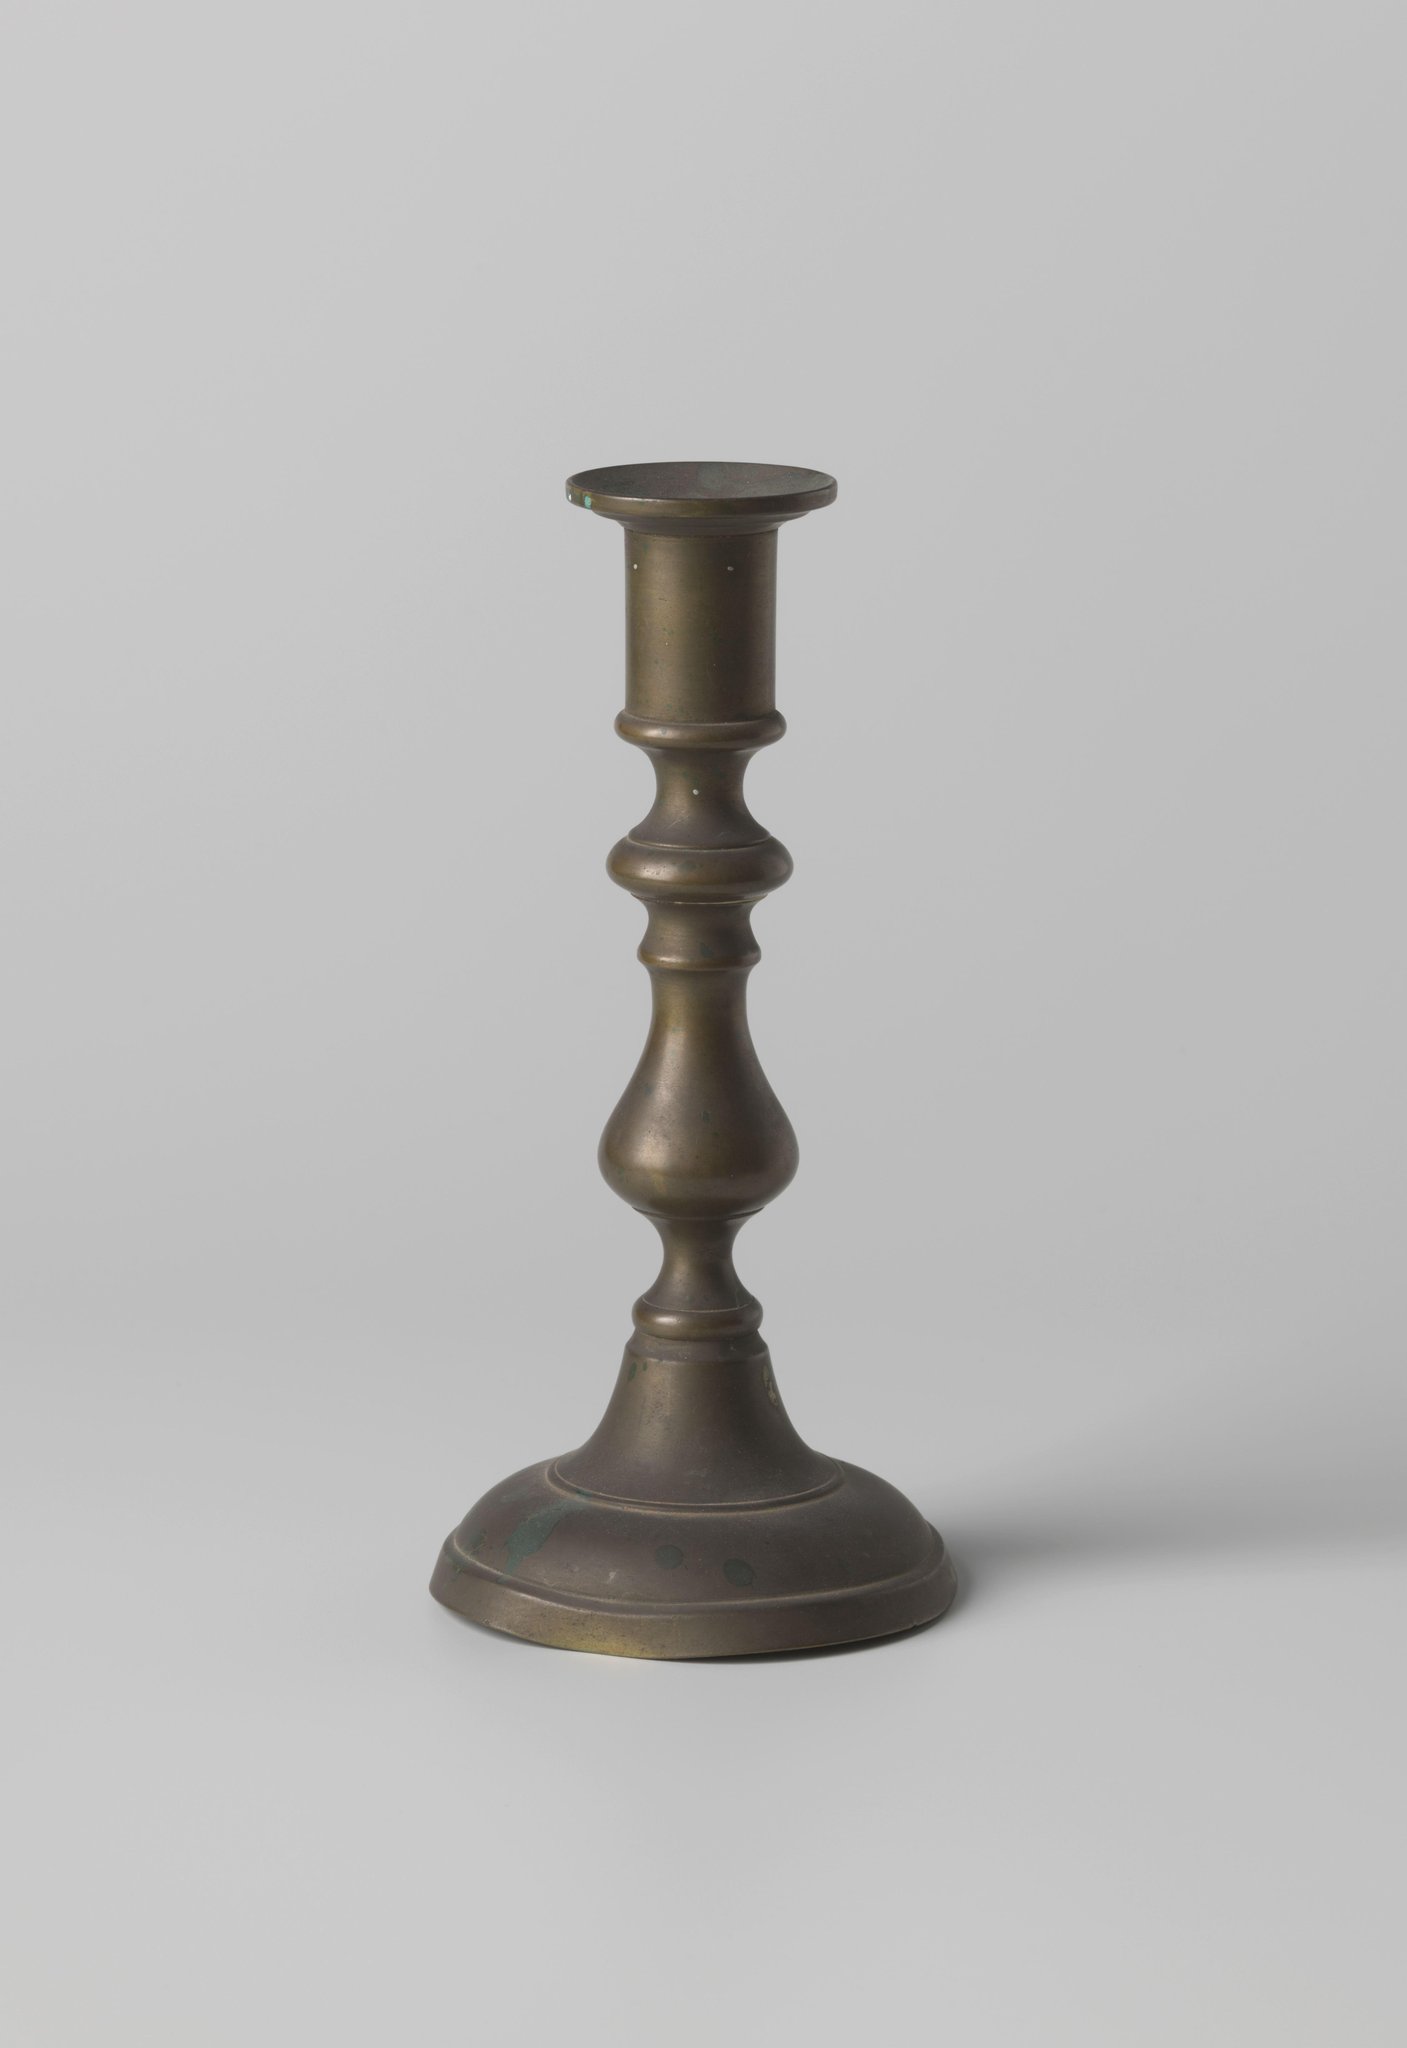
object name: candlestick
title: Messing kandelaar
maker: Anonymous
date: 1700-1750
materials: brass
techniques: casting, turning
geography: netherlands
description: De kandelaar is in twee delen gegoten en afgedraaid: de voet en de stam met kaarsenhouder. Op de geprofileerde voet is met een ijzeren pin de balustervormige stam vastgezet. De kaarsenhouder is cilindervormig met rechte wanden en een brede kraag.